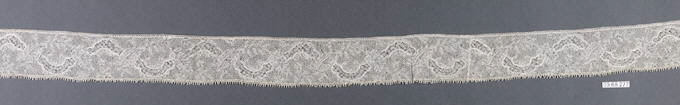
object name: strip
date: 1701-1800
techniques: lace